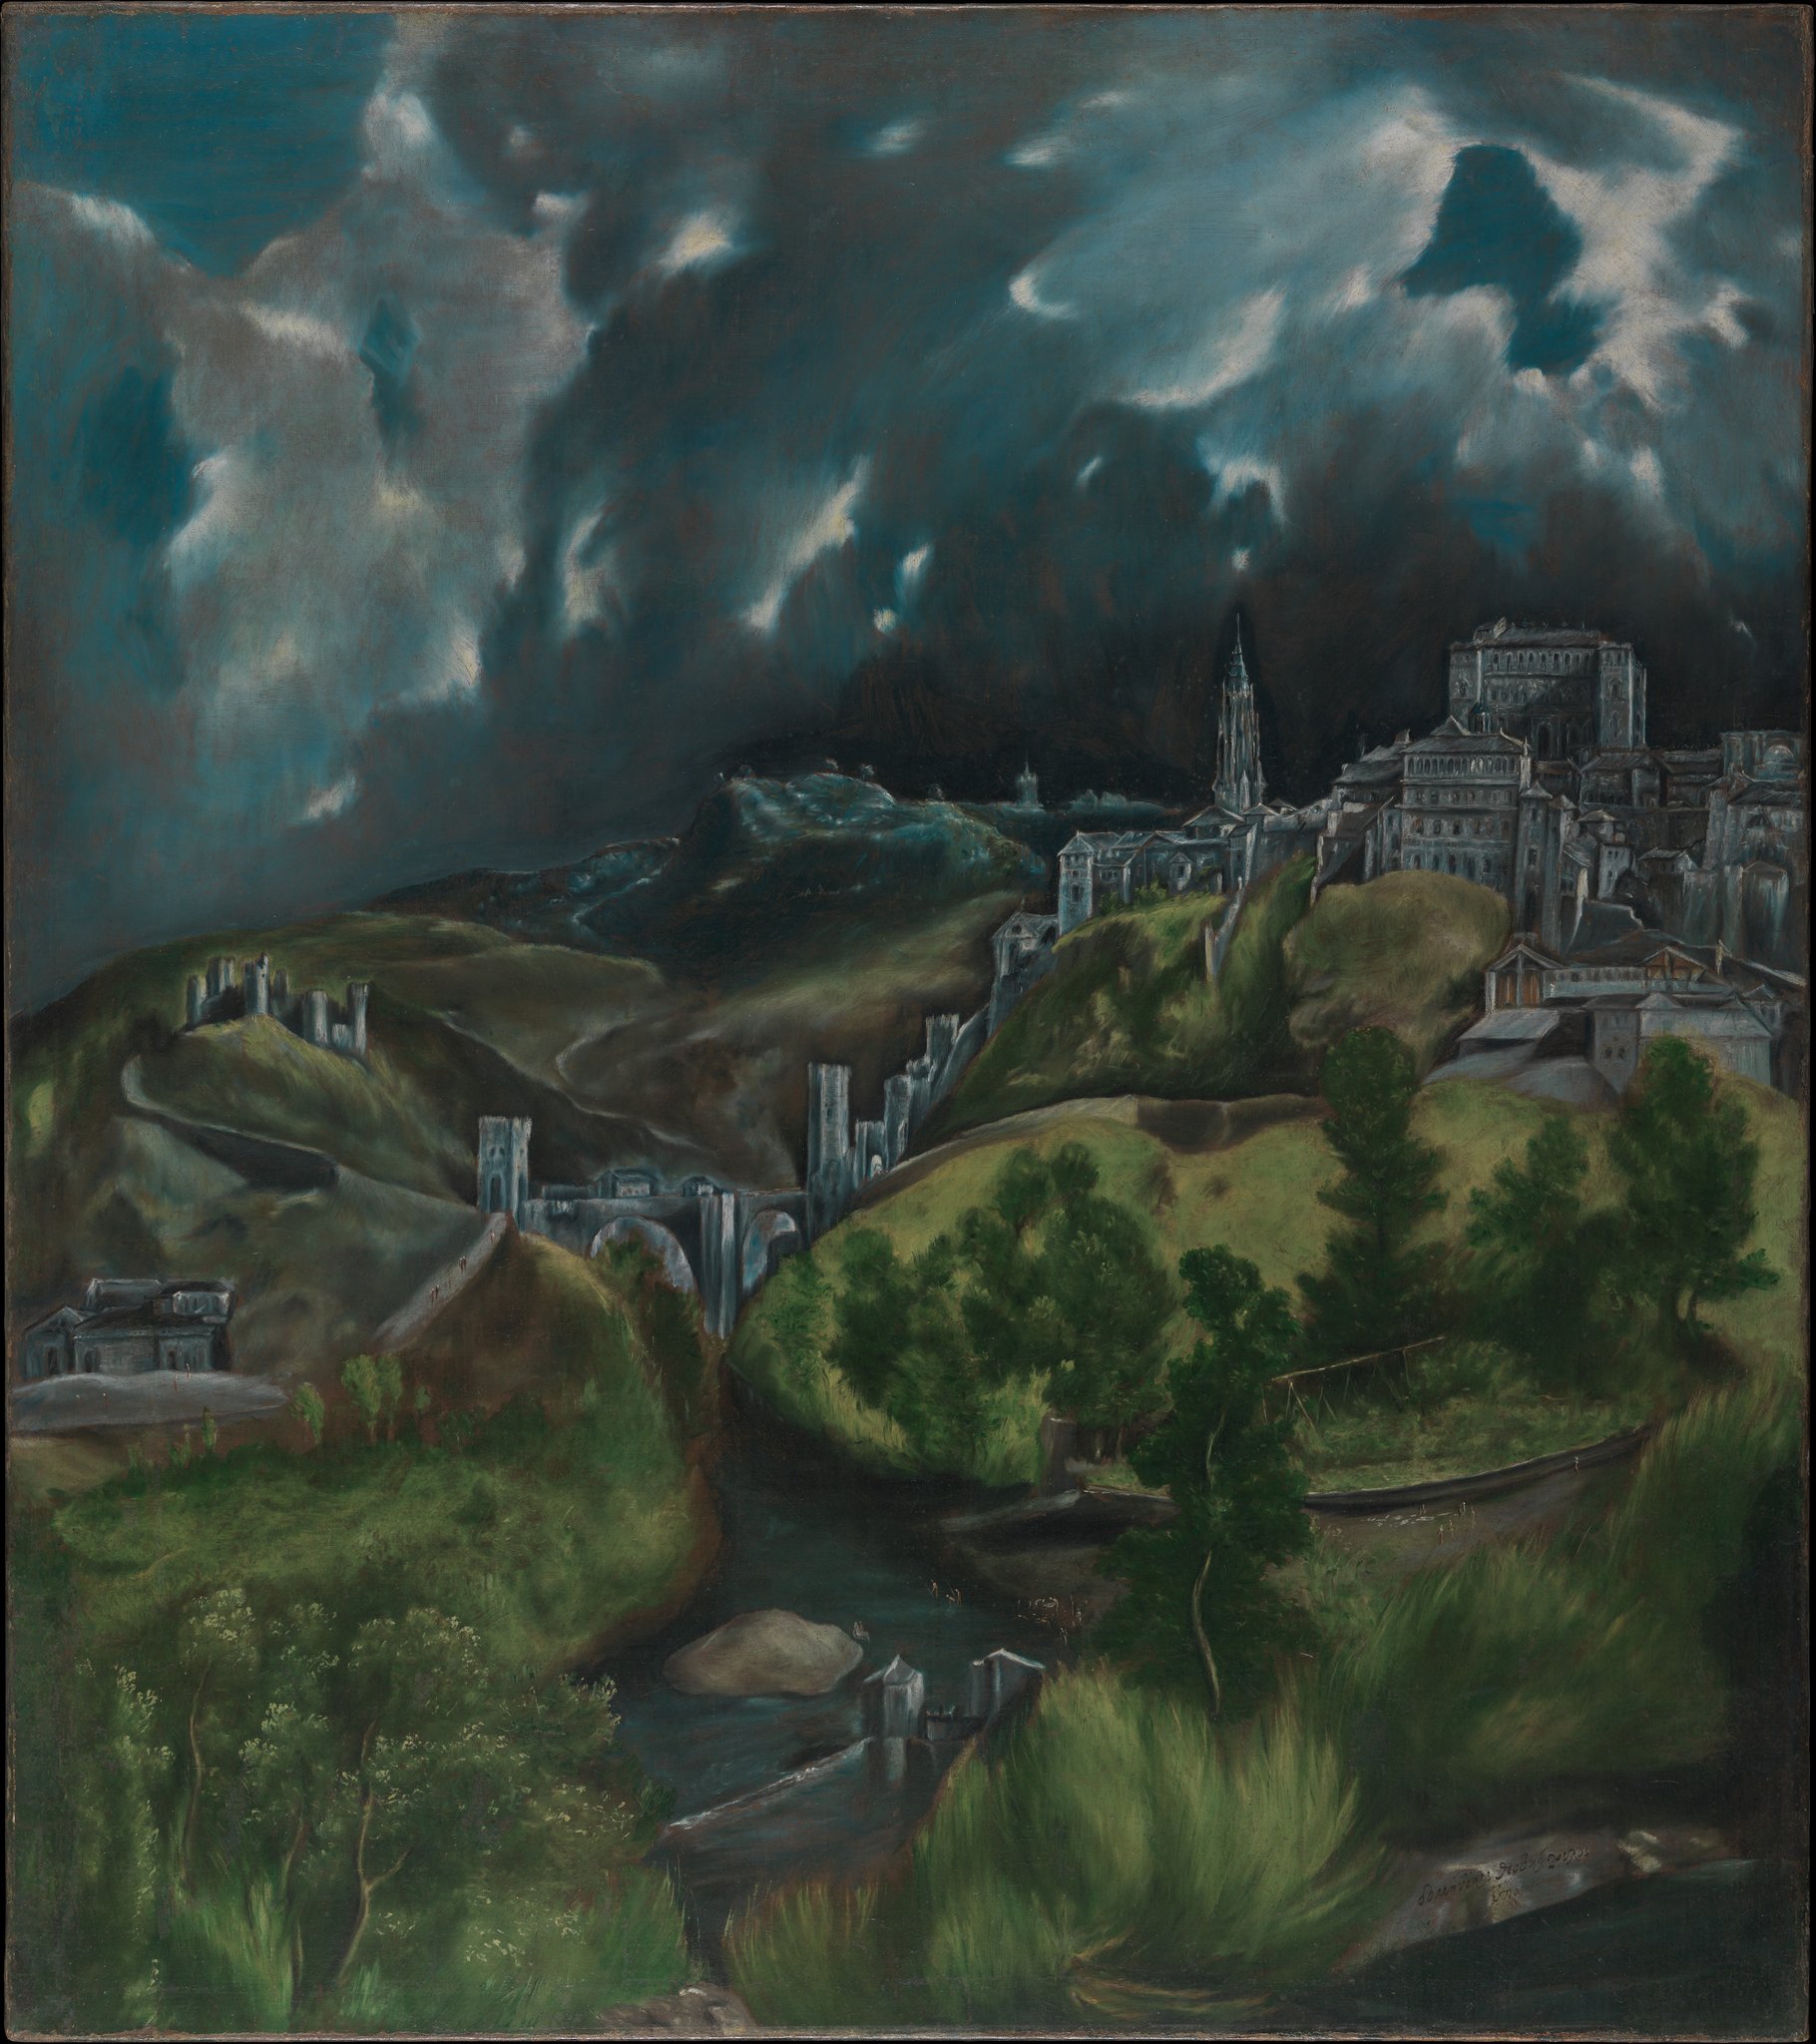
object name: painting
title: View of Toledo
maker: el greco (domenikos theotokopoulos)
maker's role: artist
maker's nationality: greek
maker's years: 1540-1614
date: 1599-1600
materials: canvas, oil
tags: buildings,cities